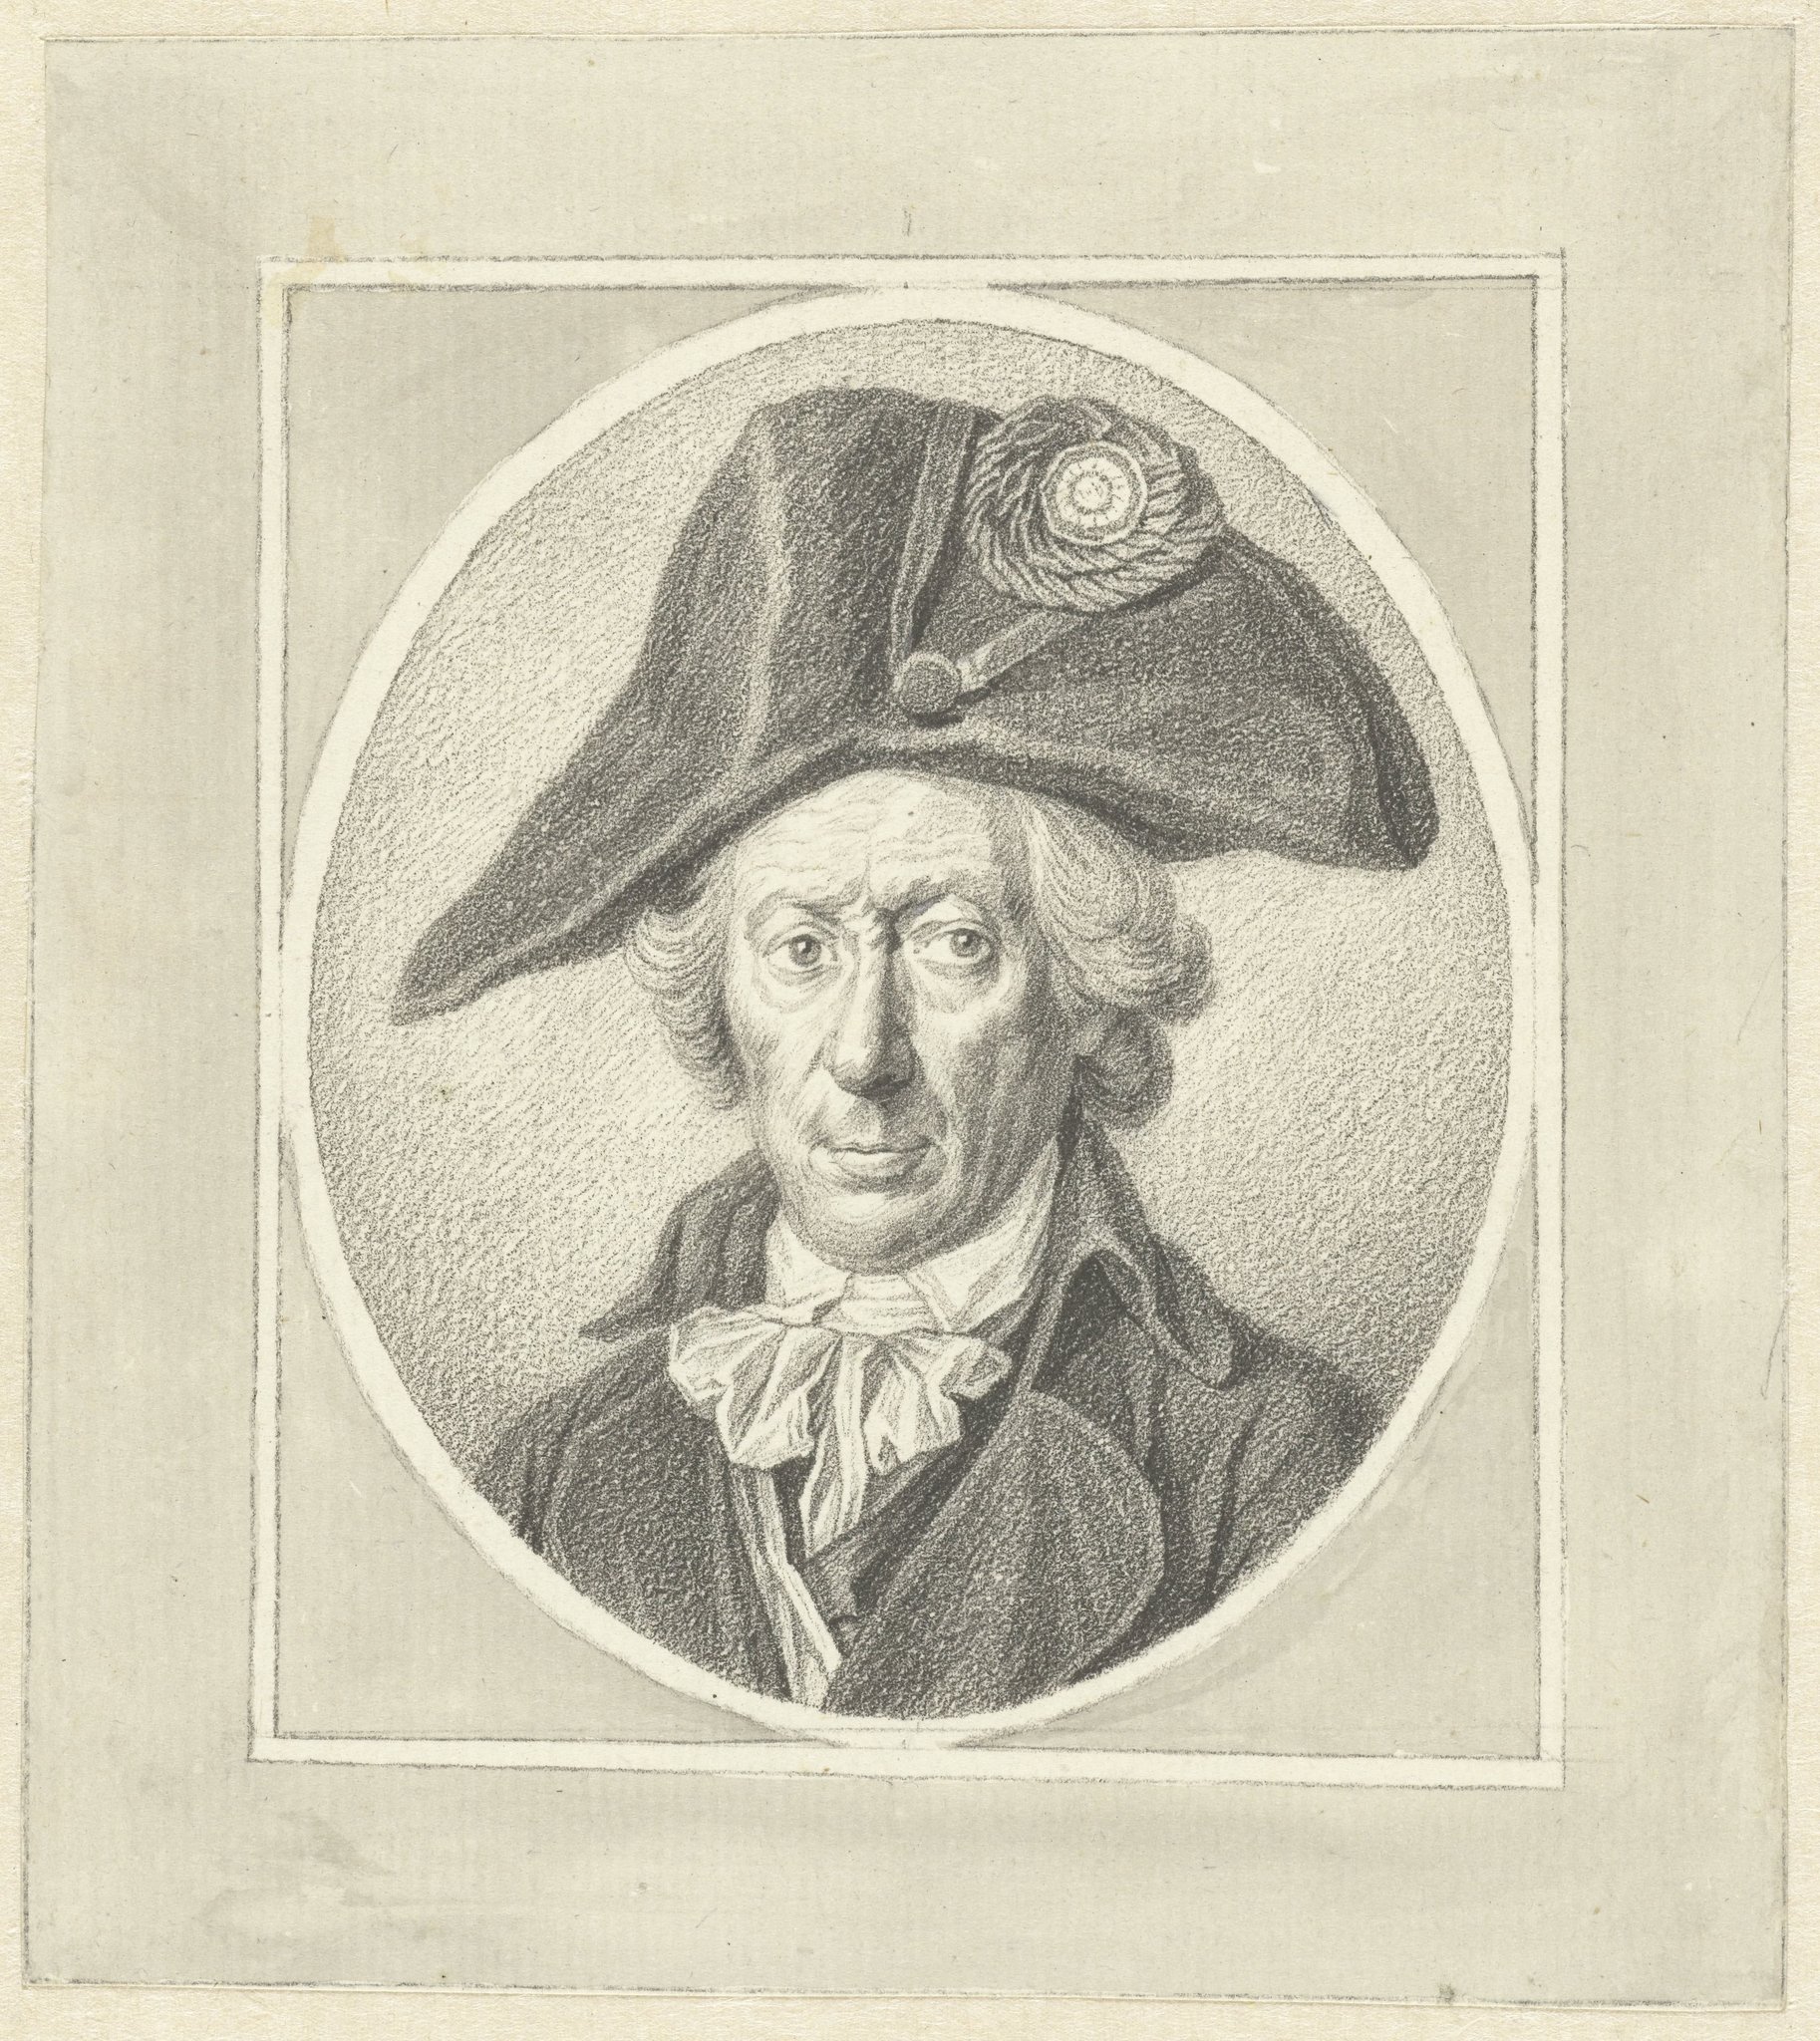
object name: drawing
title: Portret van Hendrik Nobbe, waterbaljuw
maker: johannes cornelis mertens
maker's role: draughtsman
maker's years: 1742-1823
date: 1752-1823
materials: chalk, paper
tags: mayor, historical persons